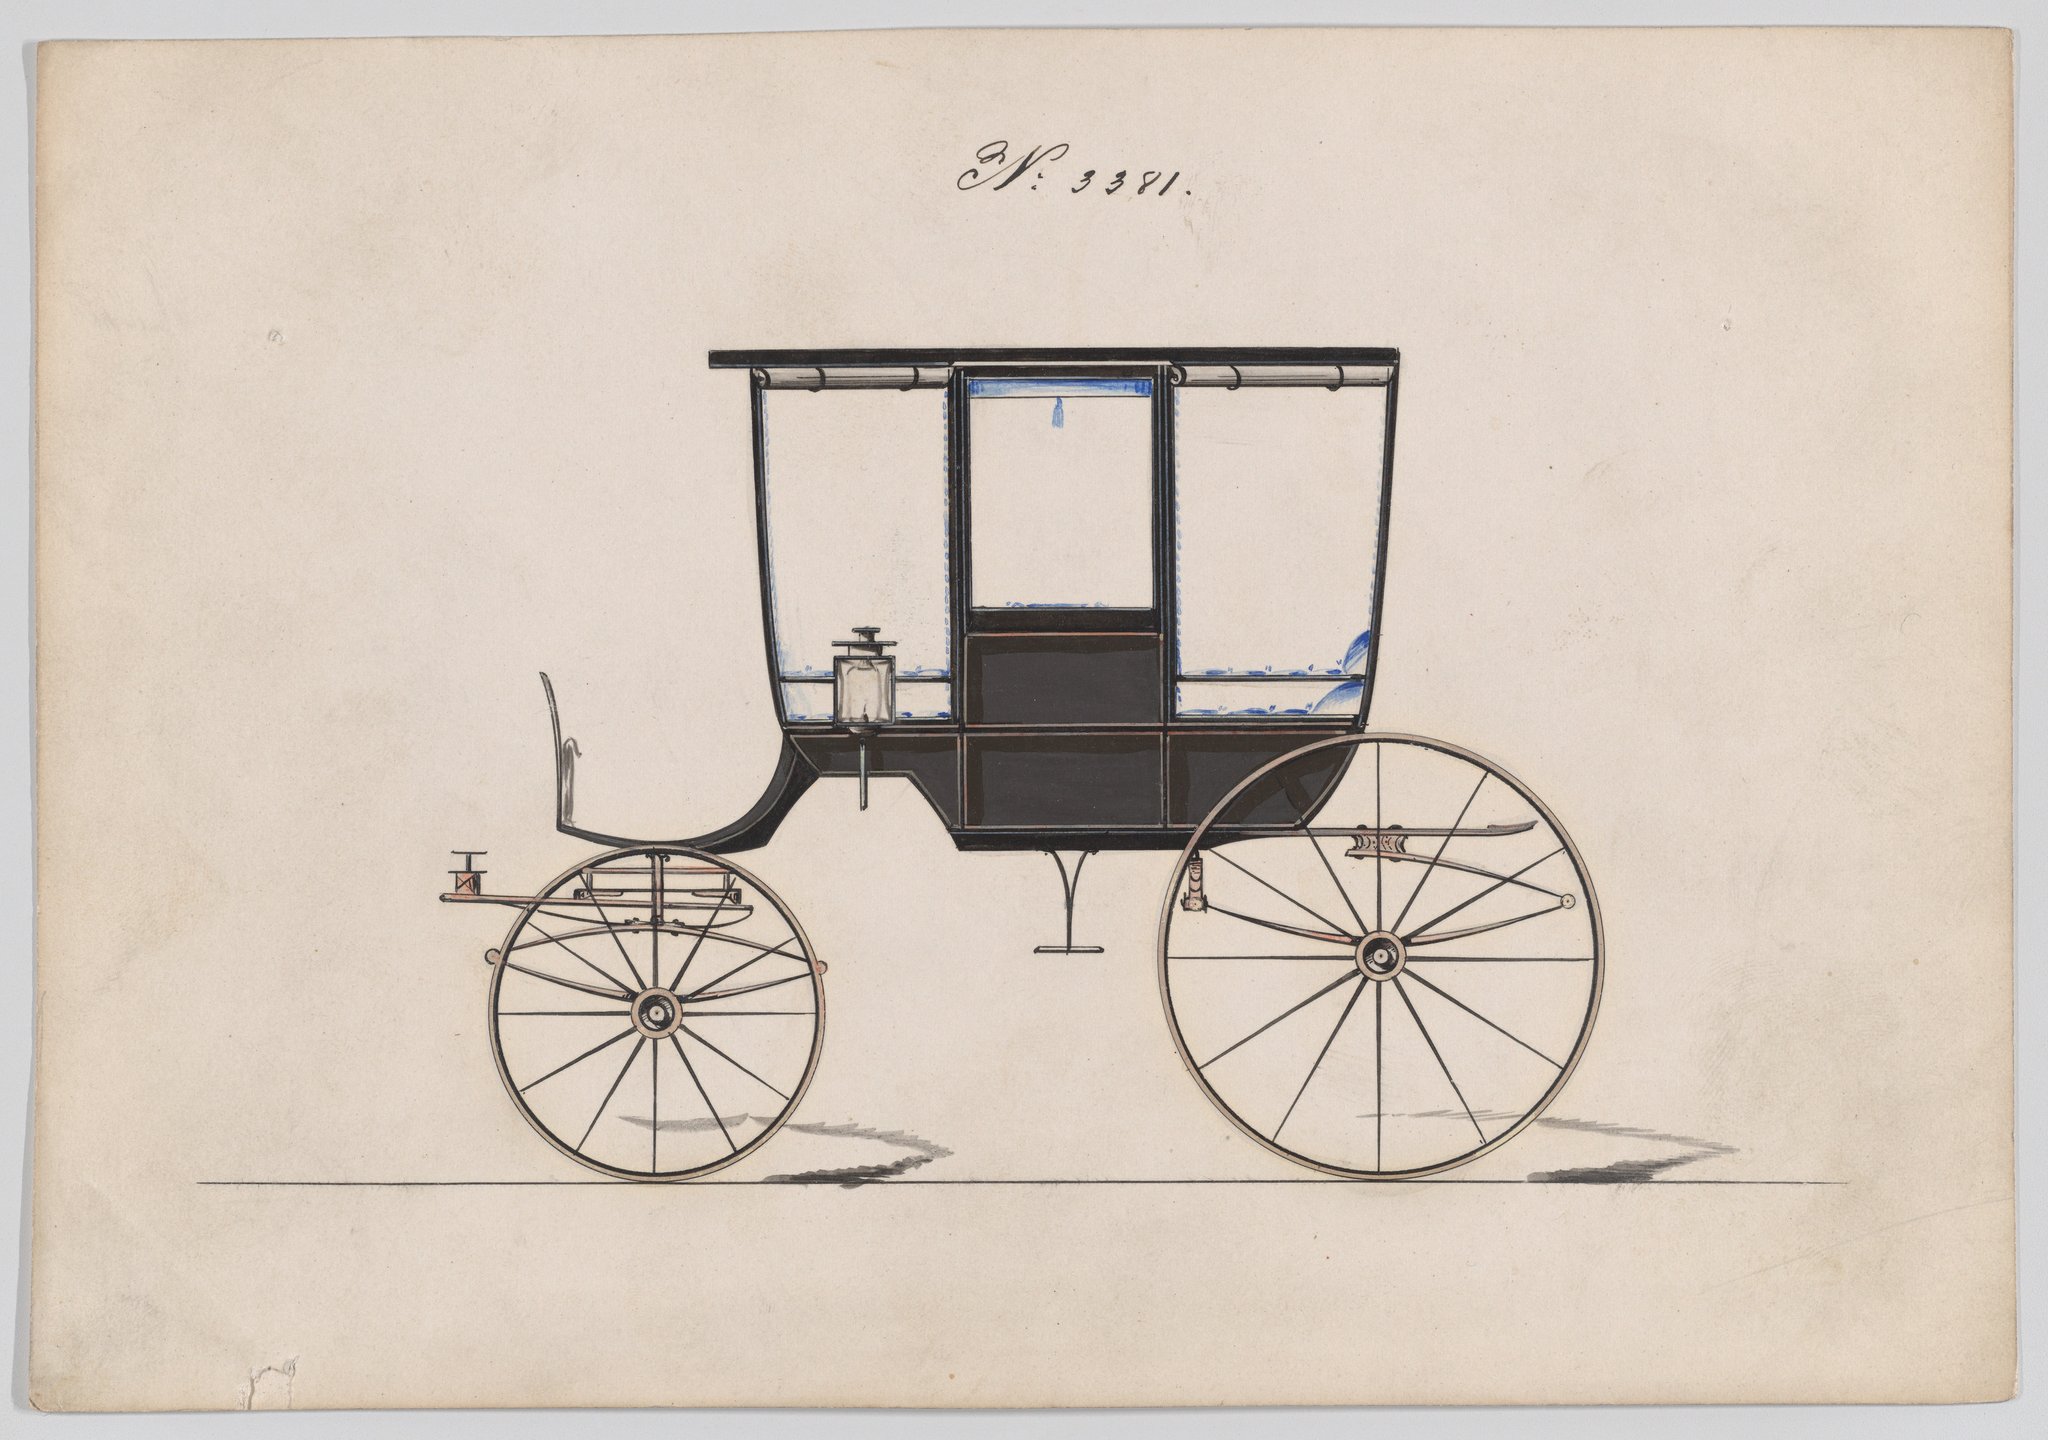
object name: drawing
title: Design for 6 seat Rockaway, no. 3381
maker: brewster & co.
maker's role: manufacturer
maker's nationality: american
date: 1877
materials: gouache, gum arabic, ink, watercolor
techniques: pen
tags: carriages